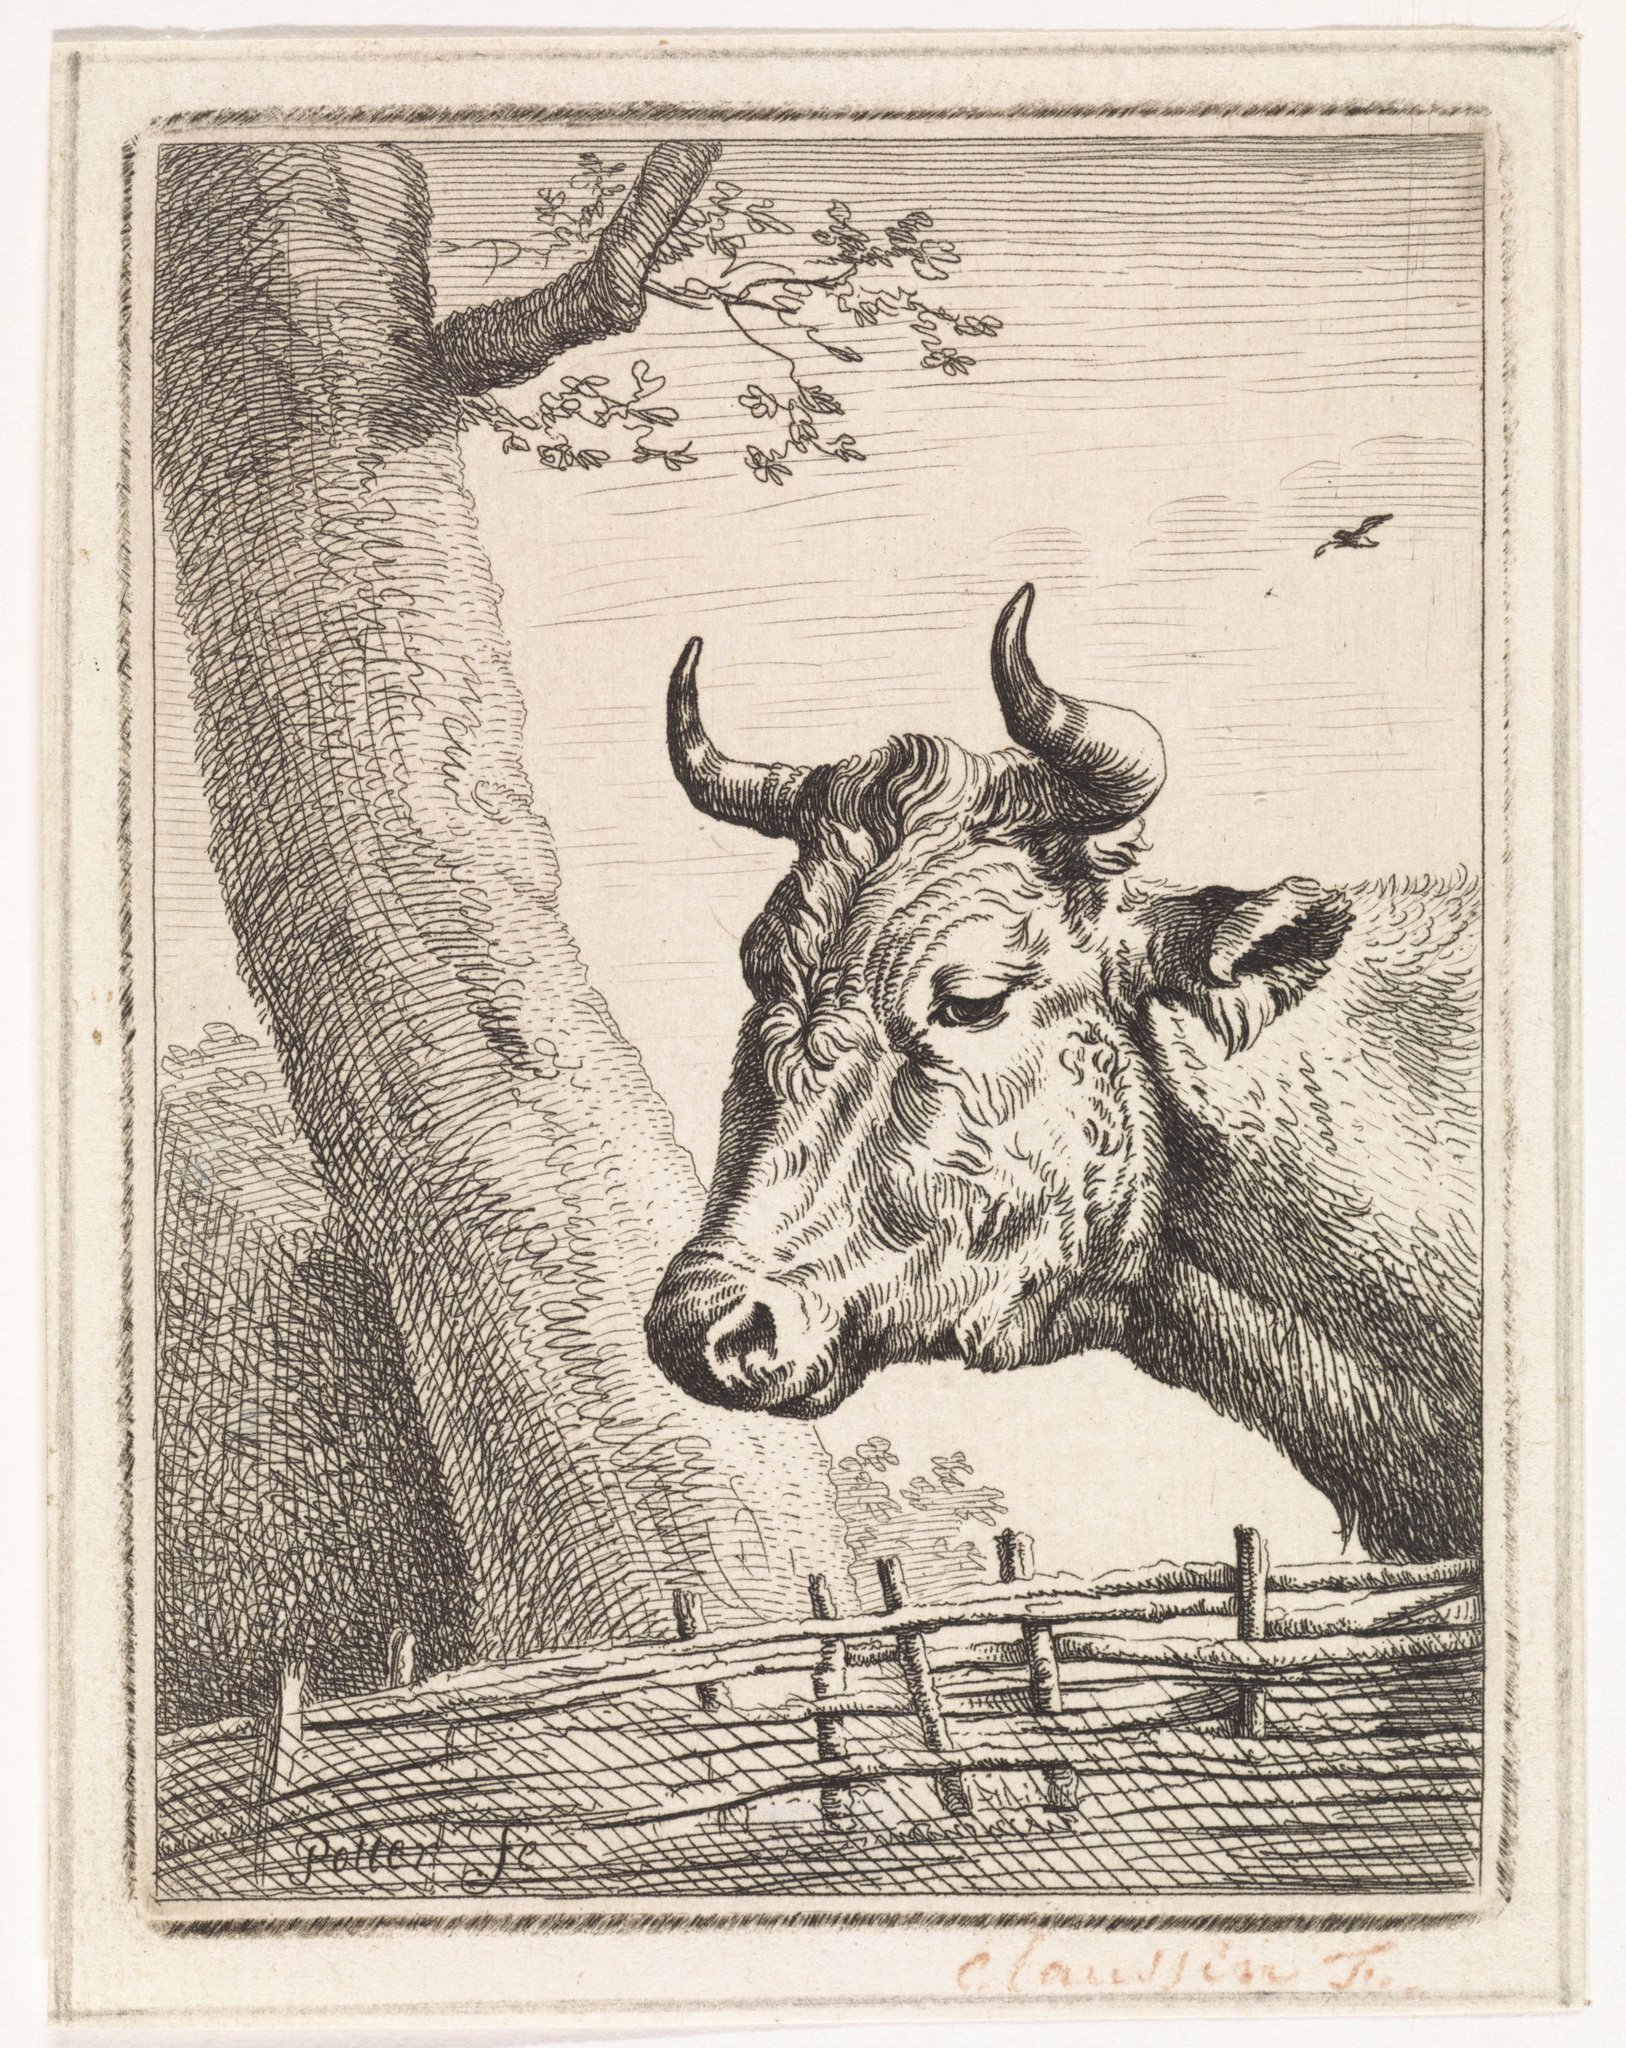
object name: print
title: Kop van een koe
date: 1805-1844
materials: paper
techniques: etching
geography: netherlands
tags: cow, fence, wall, paling, animals (+ head of an animal)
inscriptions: collector's mark: Lugt 2228, collector's mark: Lugt 2227